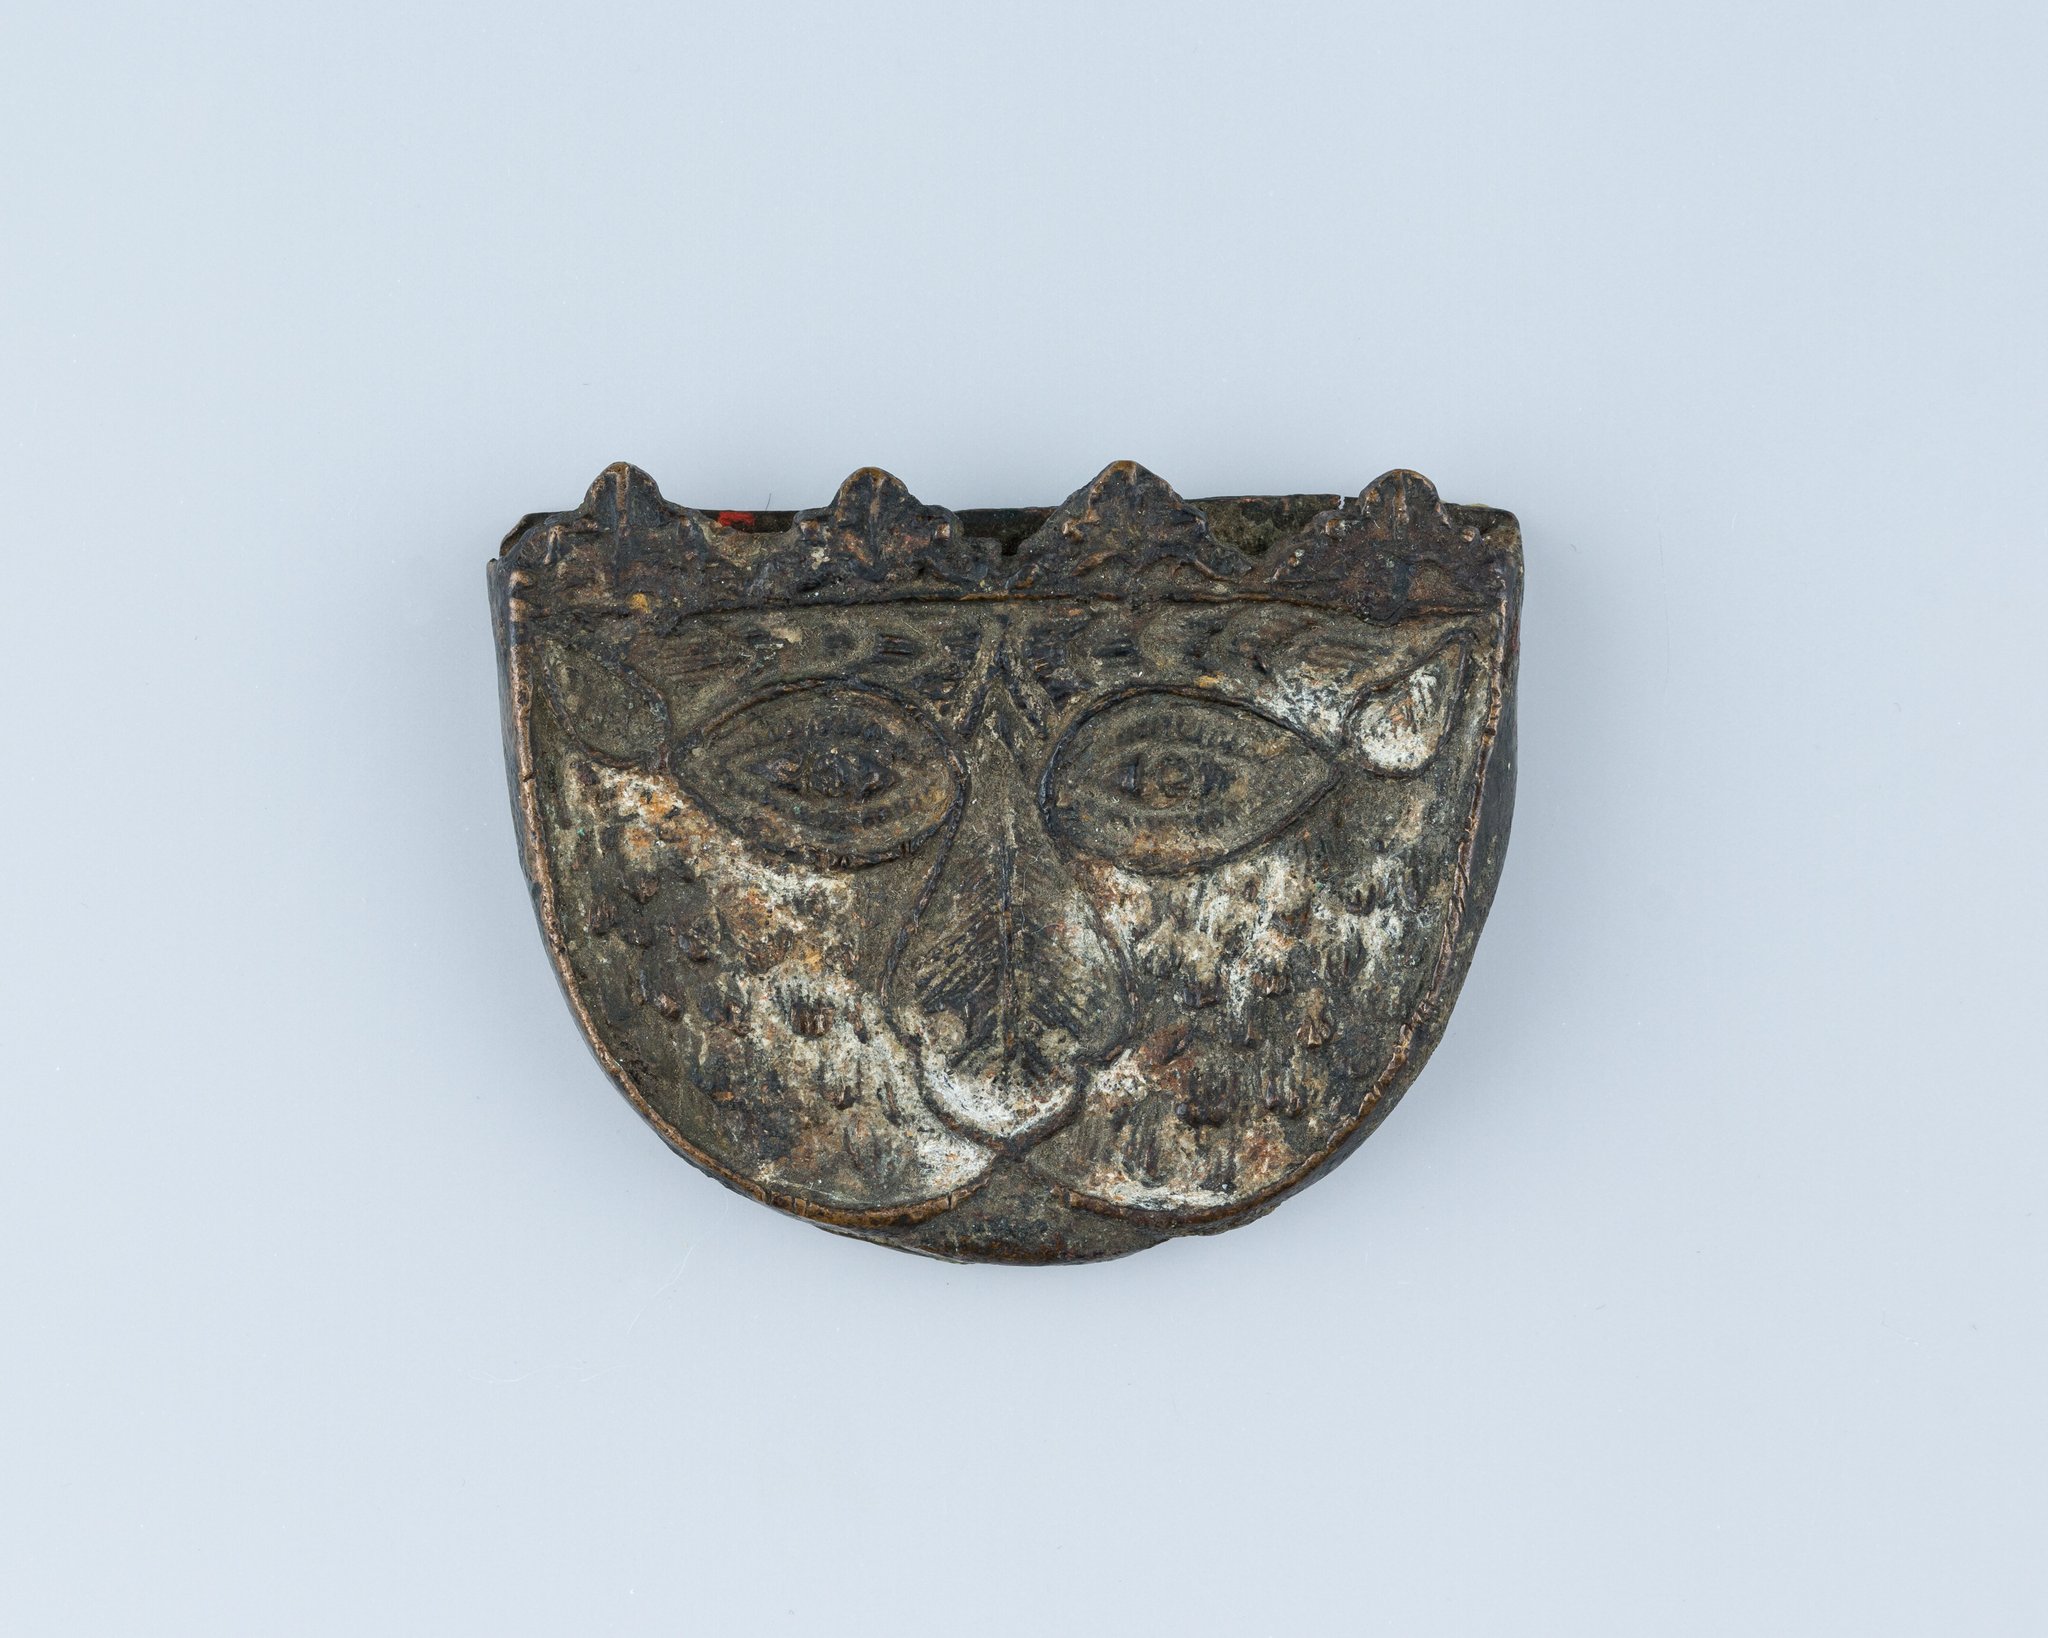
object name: mordant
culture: visigothic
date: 409-711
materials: bronze